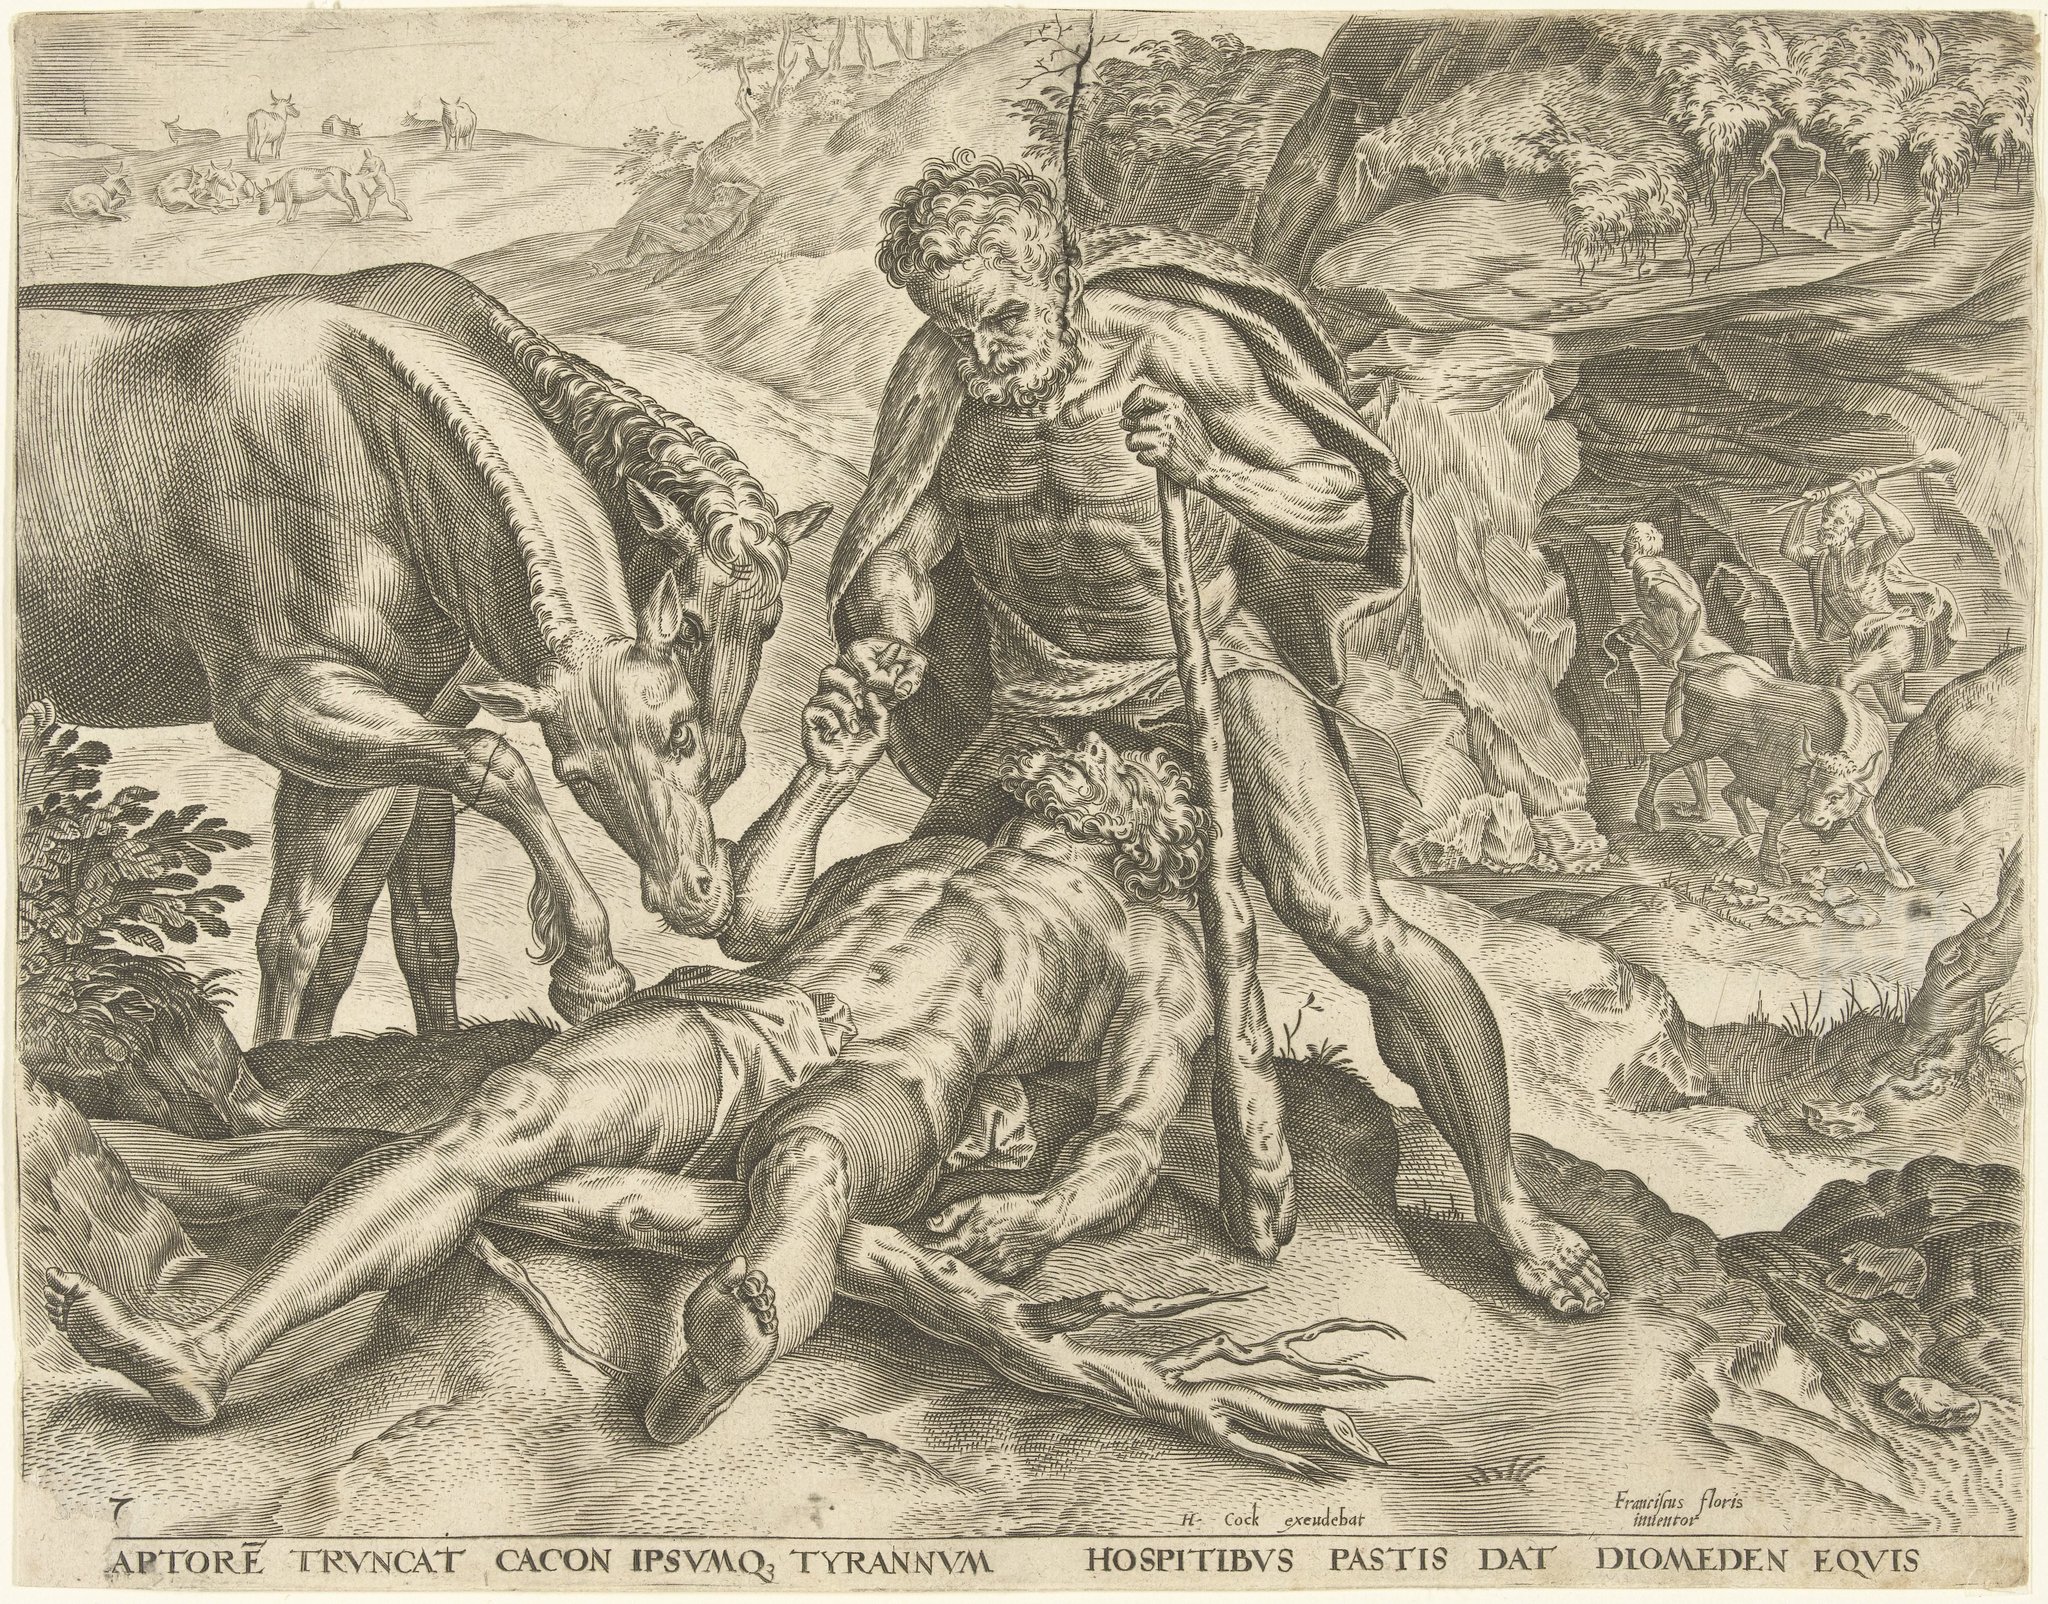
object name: print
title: Werken van Hercules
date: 1563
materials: paper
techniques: engraving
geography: antwerp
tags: cacus steals some of the cattle of geryon which hercules was driving home, (8) the four mares of king diomedes are captured; when diomedes is slain in the ensuing battle his body is thrown to the mares to eat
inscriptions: collector's mark: Lugt 10, collector's mark: Lugt 11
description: De paarden van Diomedes werden met mensenvlees gevoerd. In een gevecht slaat Hercules Diomedes dood en voert vervolgens zijn lichaam aan diens paarden. Op de achtergrond is Hercules te zien die de reus Cacus doodslaat. Cacus heeft een rund uit Hercules kudde gestolen en sleept het aan zijn staat naar zijn grot. Hercules verrast hem met zijn knots.